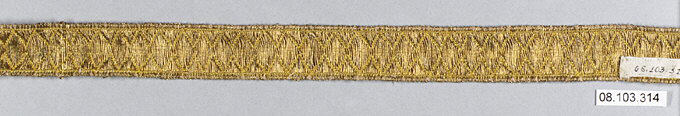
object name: galloon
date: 1601-1800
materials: metal thread